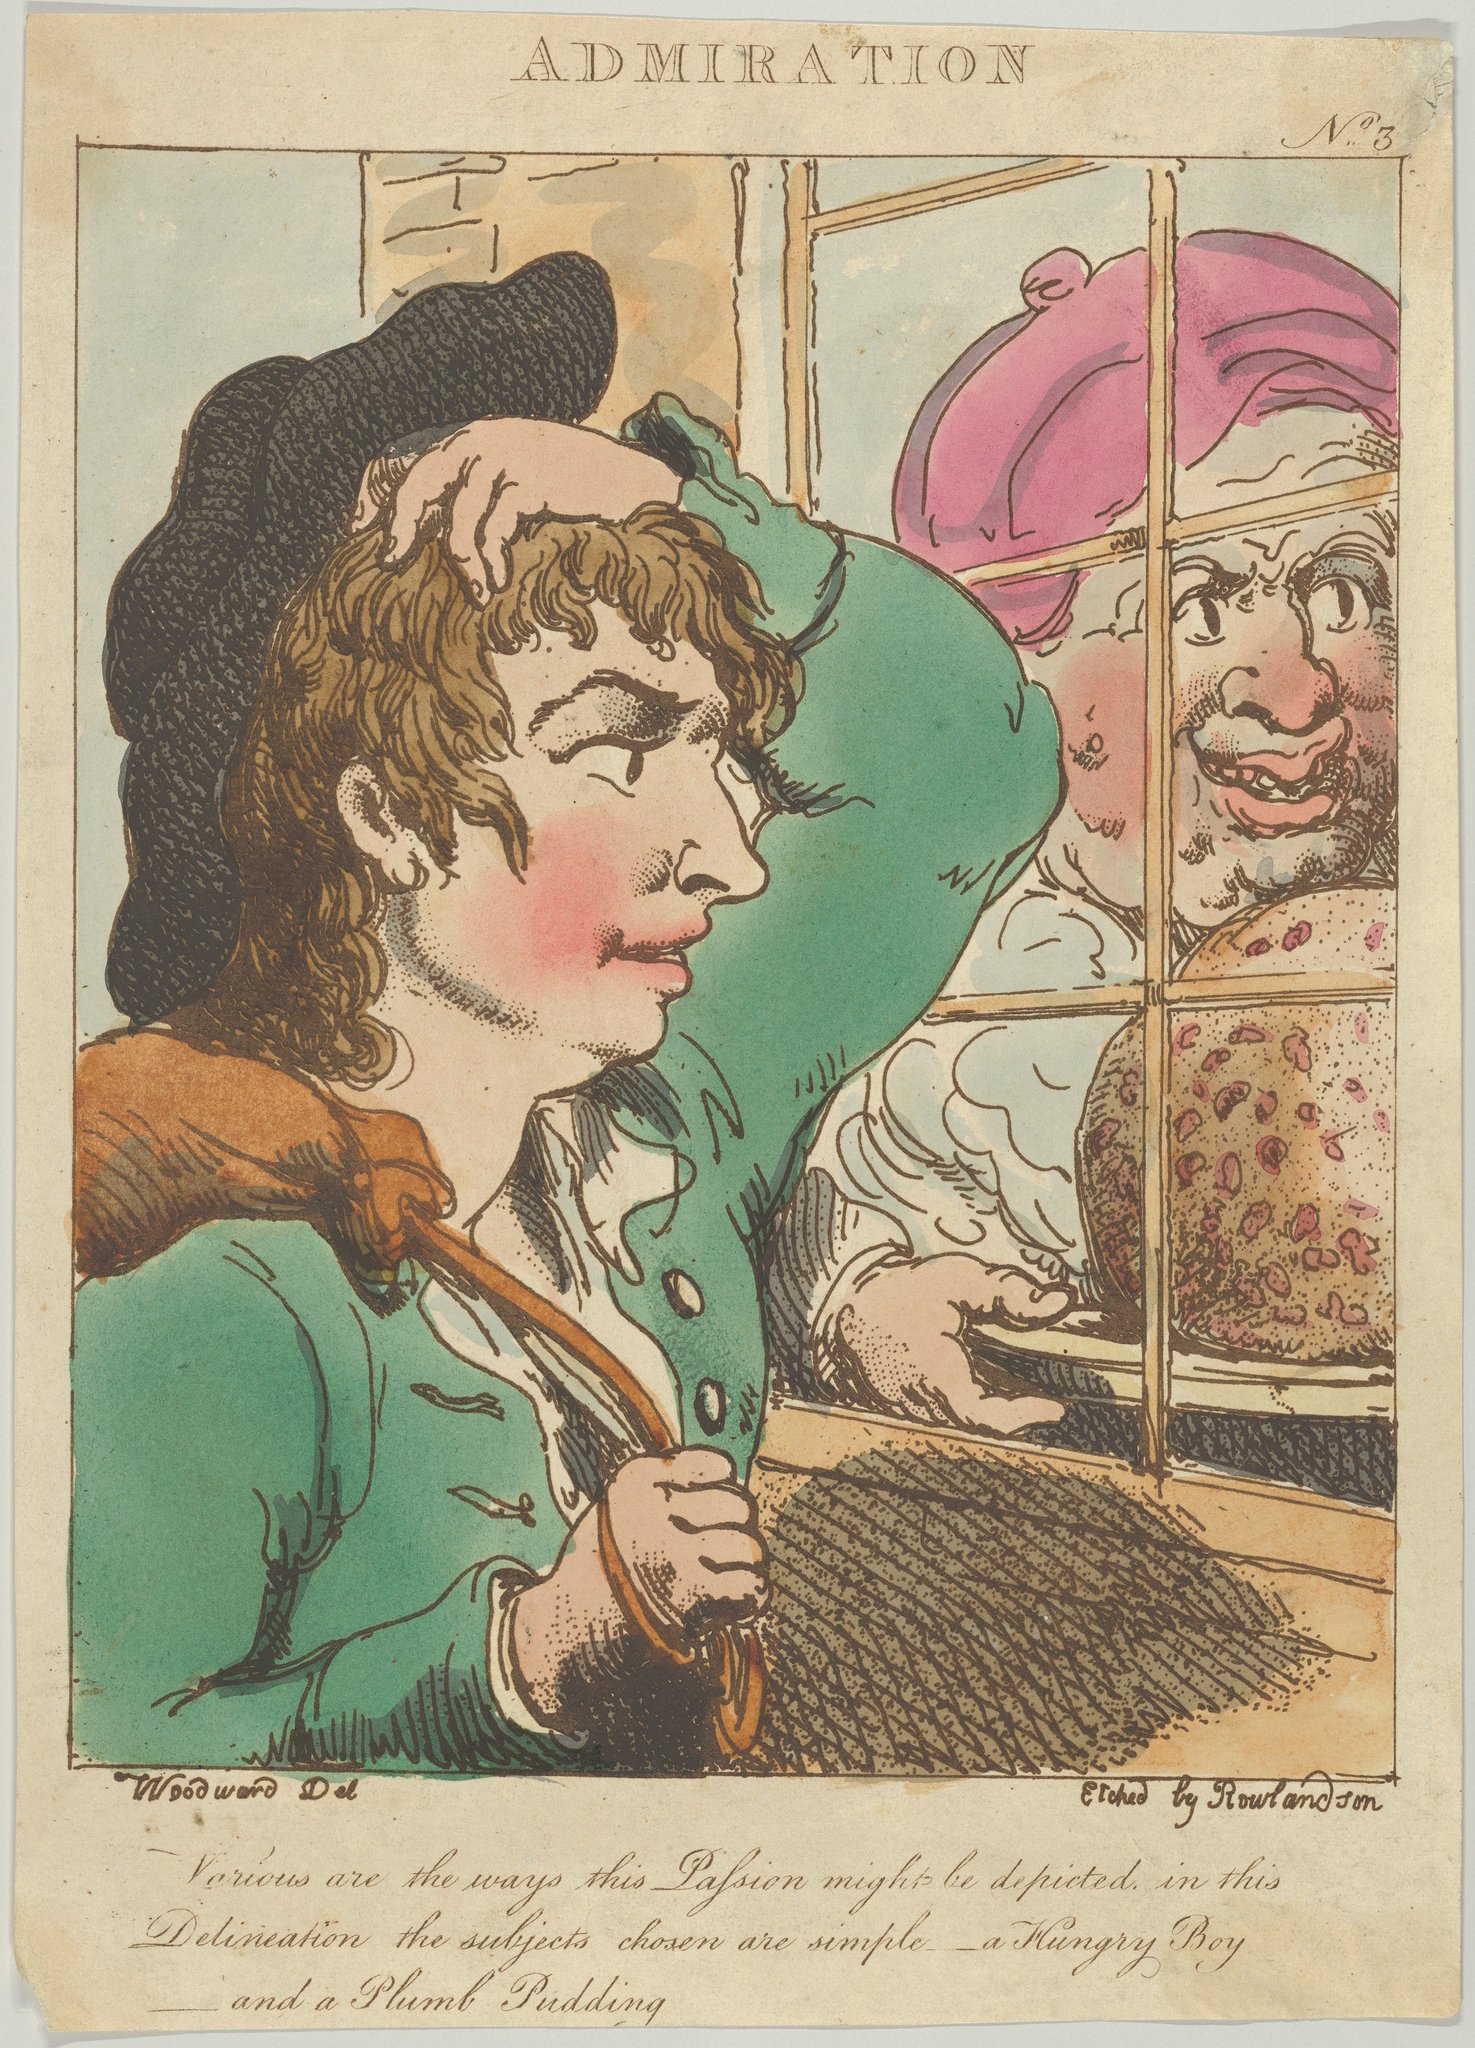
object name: print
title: Admiration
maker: thomas rowlandson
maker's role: artist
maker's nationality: british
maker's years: 1757-1827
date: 1800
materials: ink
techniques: etching, printing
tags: satire,men